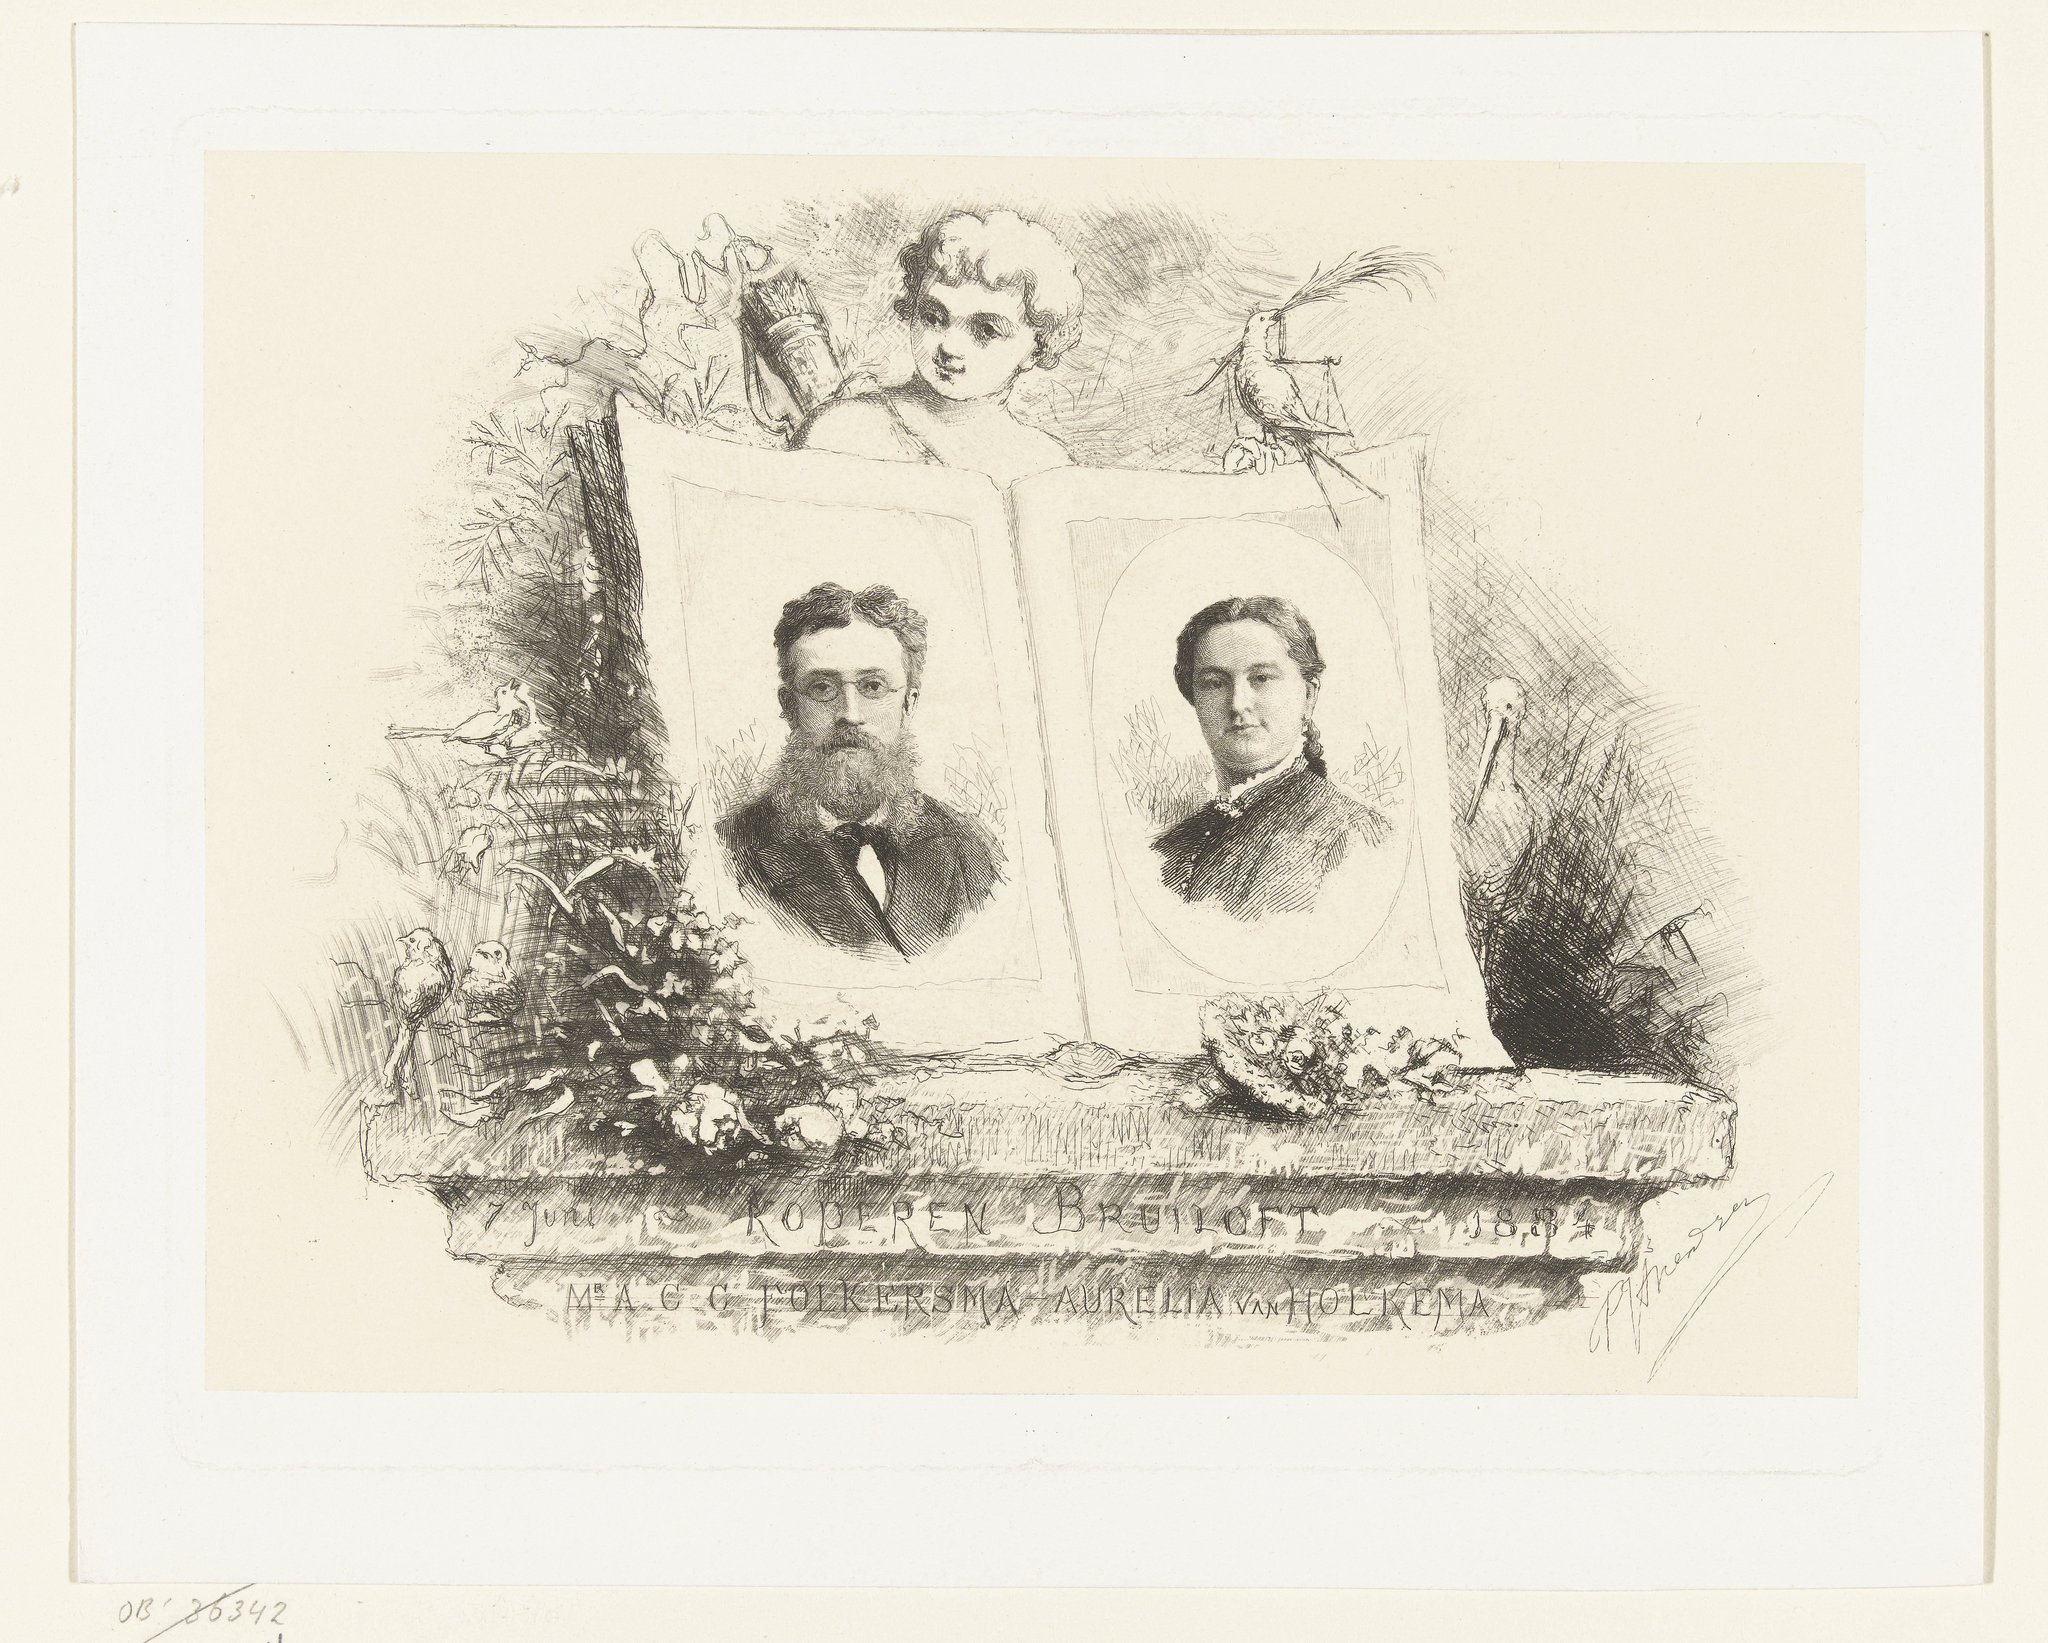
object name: print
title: Dubbelportret van A.C.C. Folkersma en Aurelia van Holkema ter gelegenheid van hun koperen bruiloft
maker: petrus johannes arendzen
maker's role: draughtsman, print maker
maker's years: 1846-1932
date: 1884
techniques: printmaking, drypoint, etching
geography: netherlands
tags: koudum, adrianus catharinus cornelis folkersma, lemmer, ommen, aurelia van holkema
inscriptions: collector's mark: Lugt 2228